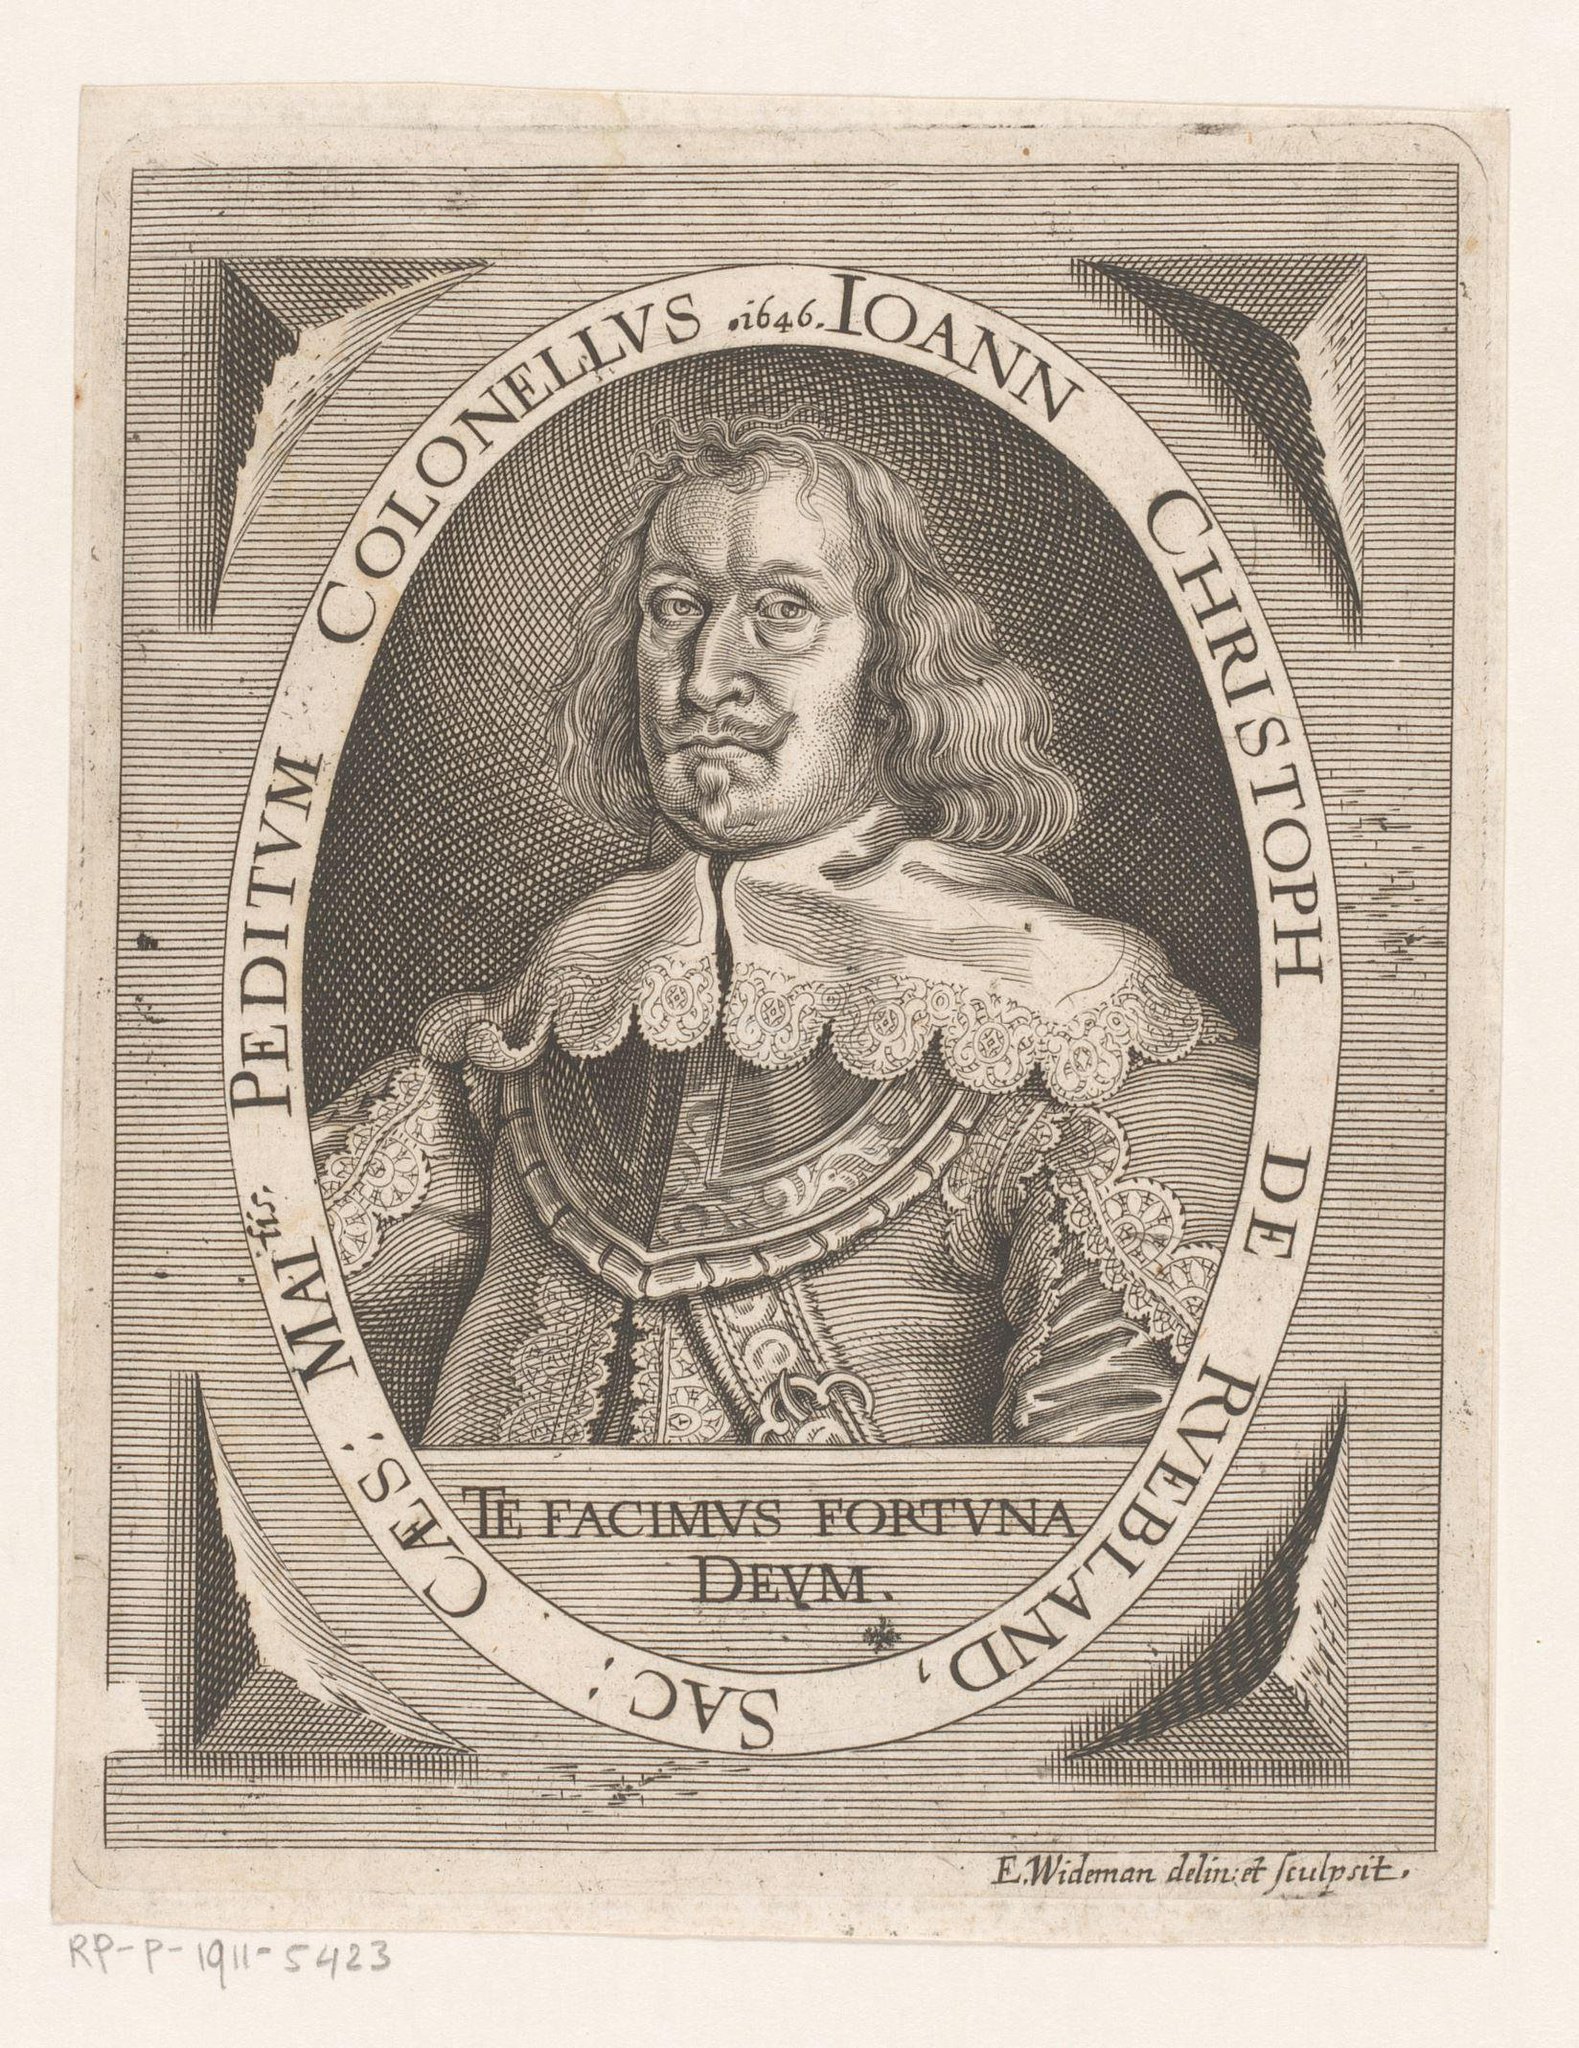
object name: print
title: Portret van Johann Christoph von Rübland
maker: elias widemann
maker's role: print maker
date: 1646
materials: paper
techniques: engraving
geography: vienna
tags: historical persons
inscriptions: collector's mark: Lugt 2228